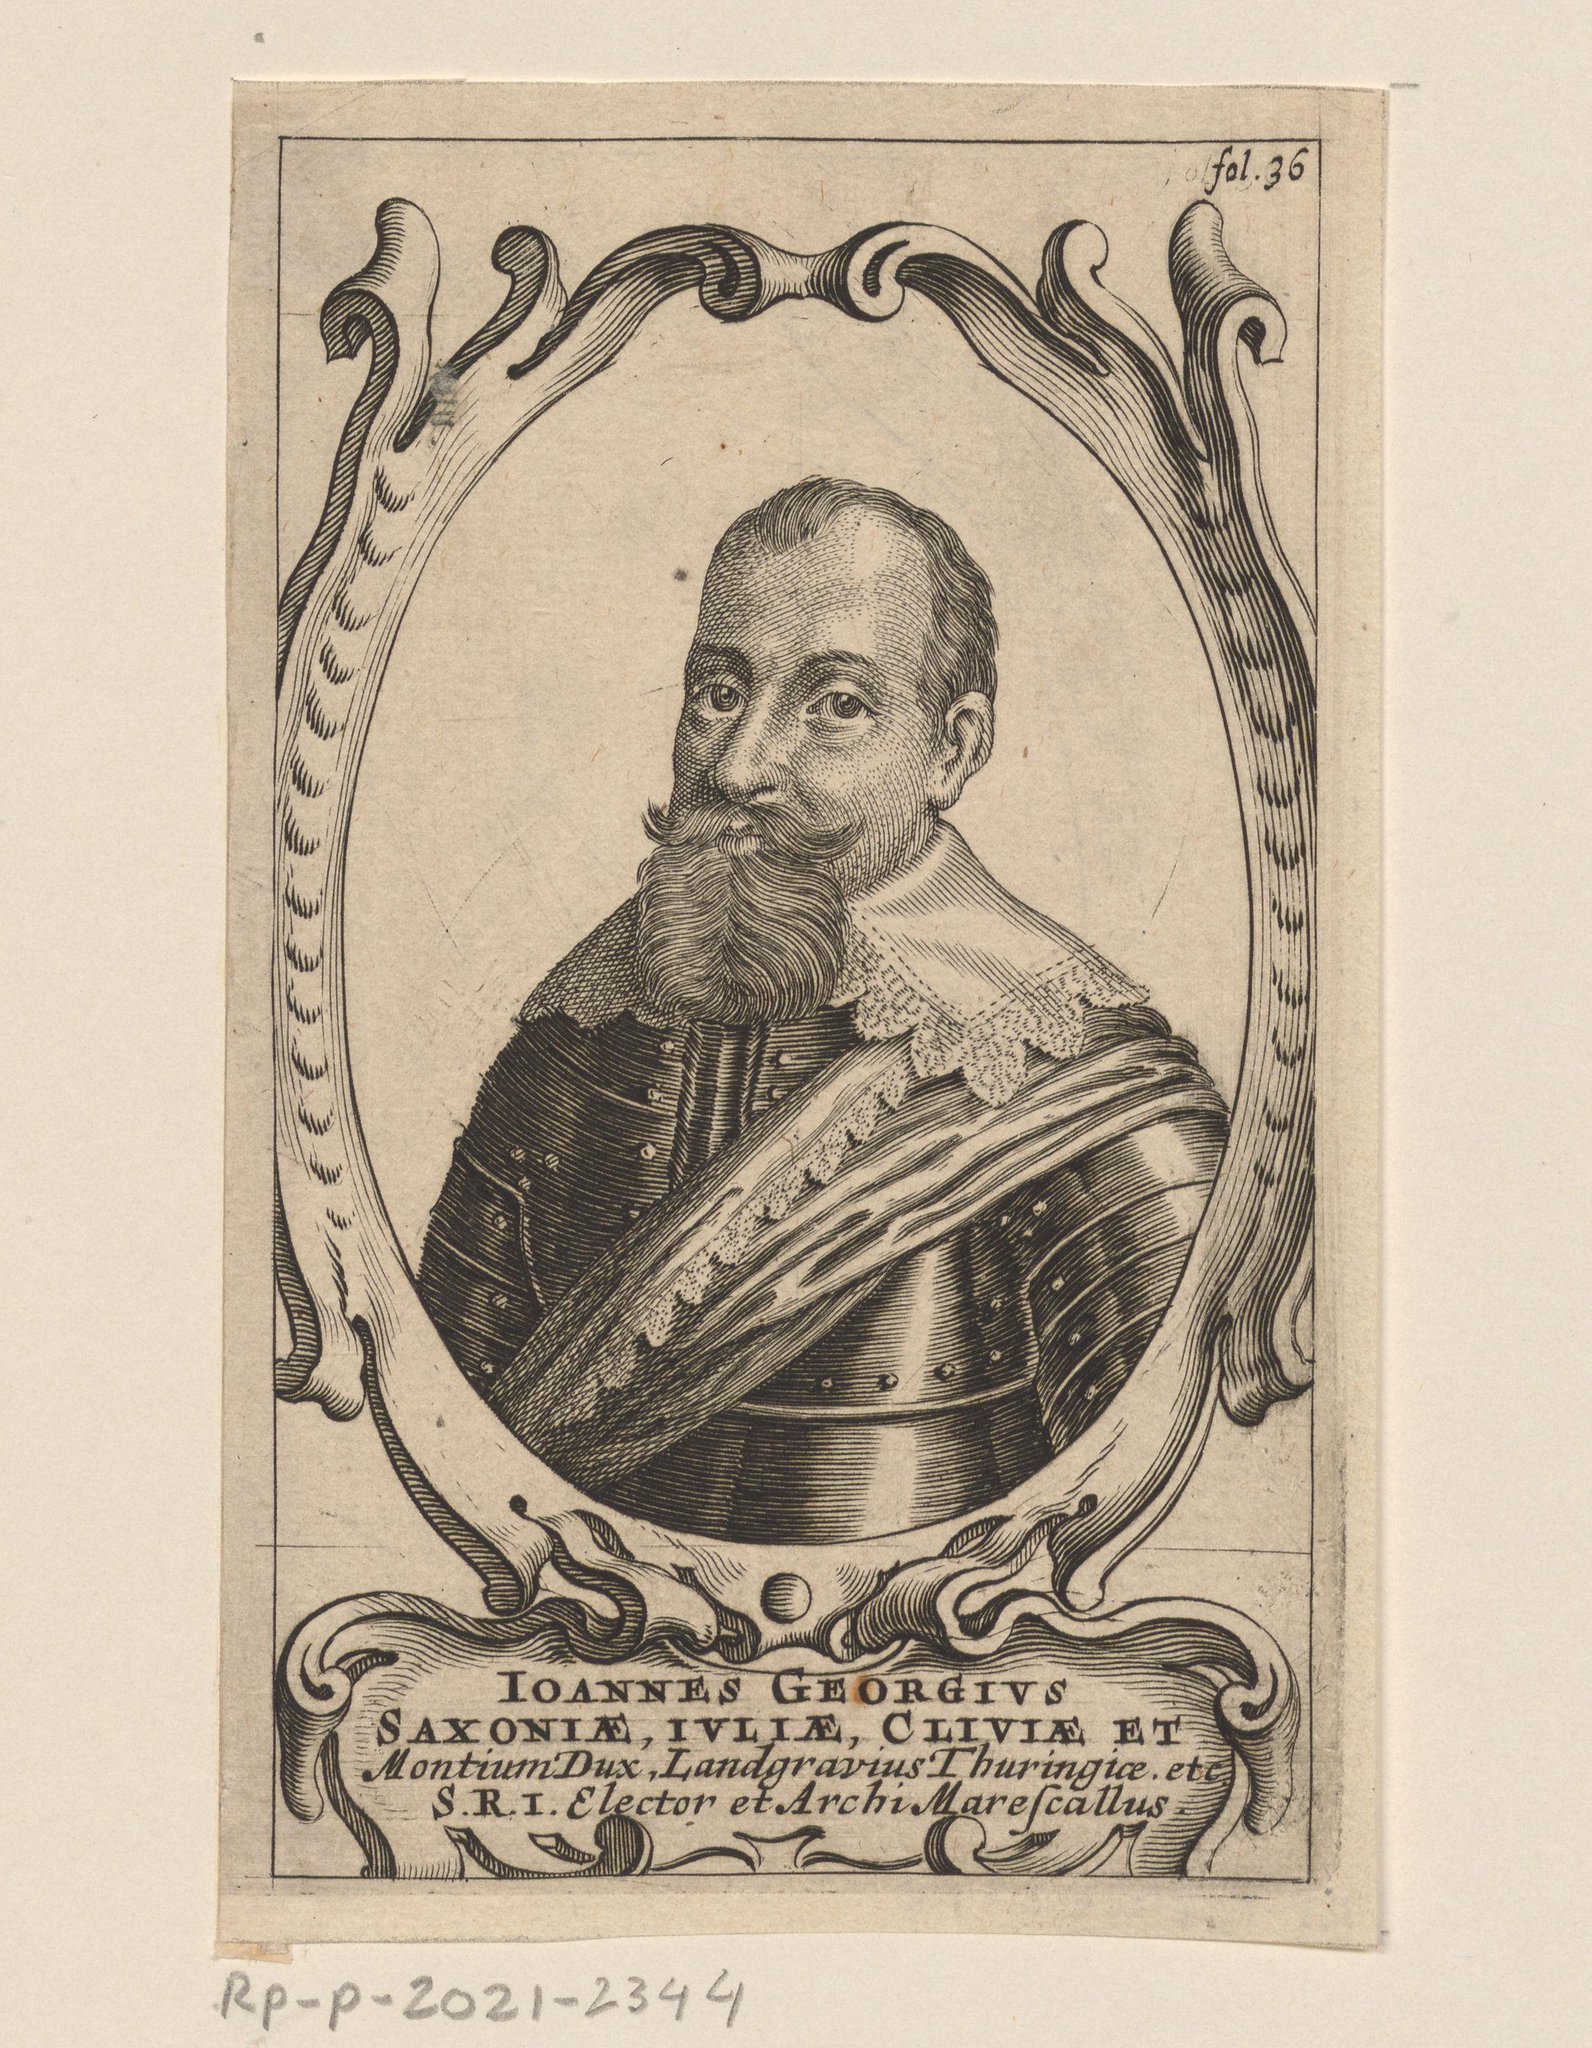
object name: print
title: Portret van Johann George I van Saksen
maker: Anonymous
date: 1656-1666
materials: paper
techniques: engraving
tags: johann george van saksen (i), historical persons, ruler, sovereign, armorial bearing, heraldry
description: Prent mogelijk uit: Brachelius, Johannes Adolphus. Historia nostri temporis, dat is geschiedenis onses tijts (…). Rotterdam: Andries van Hoogenhuysen, 1656. Of uit latere publicaties (1659 en 1666).